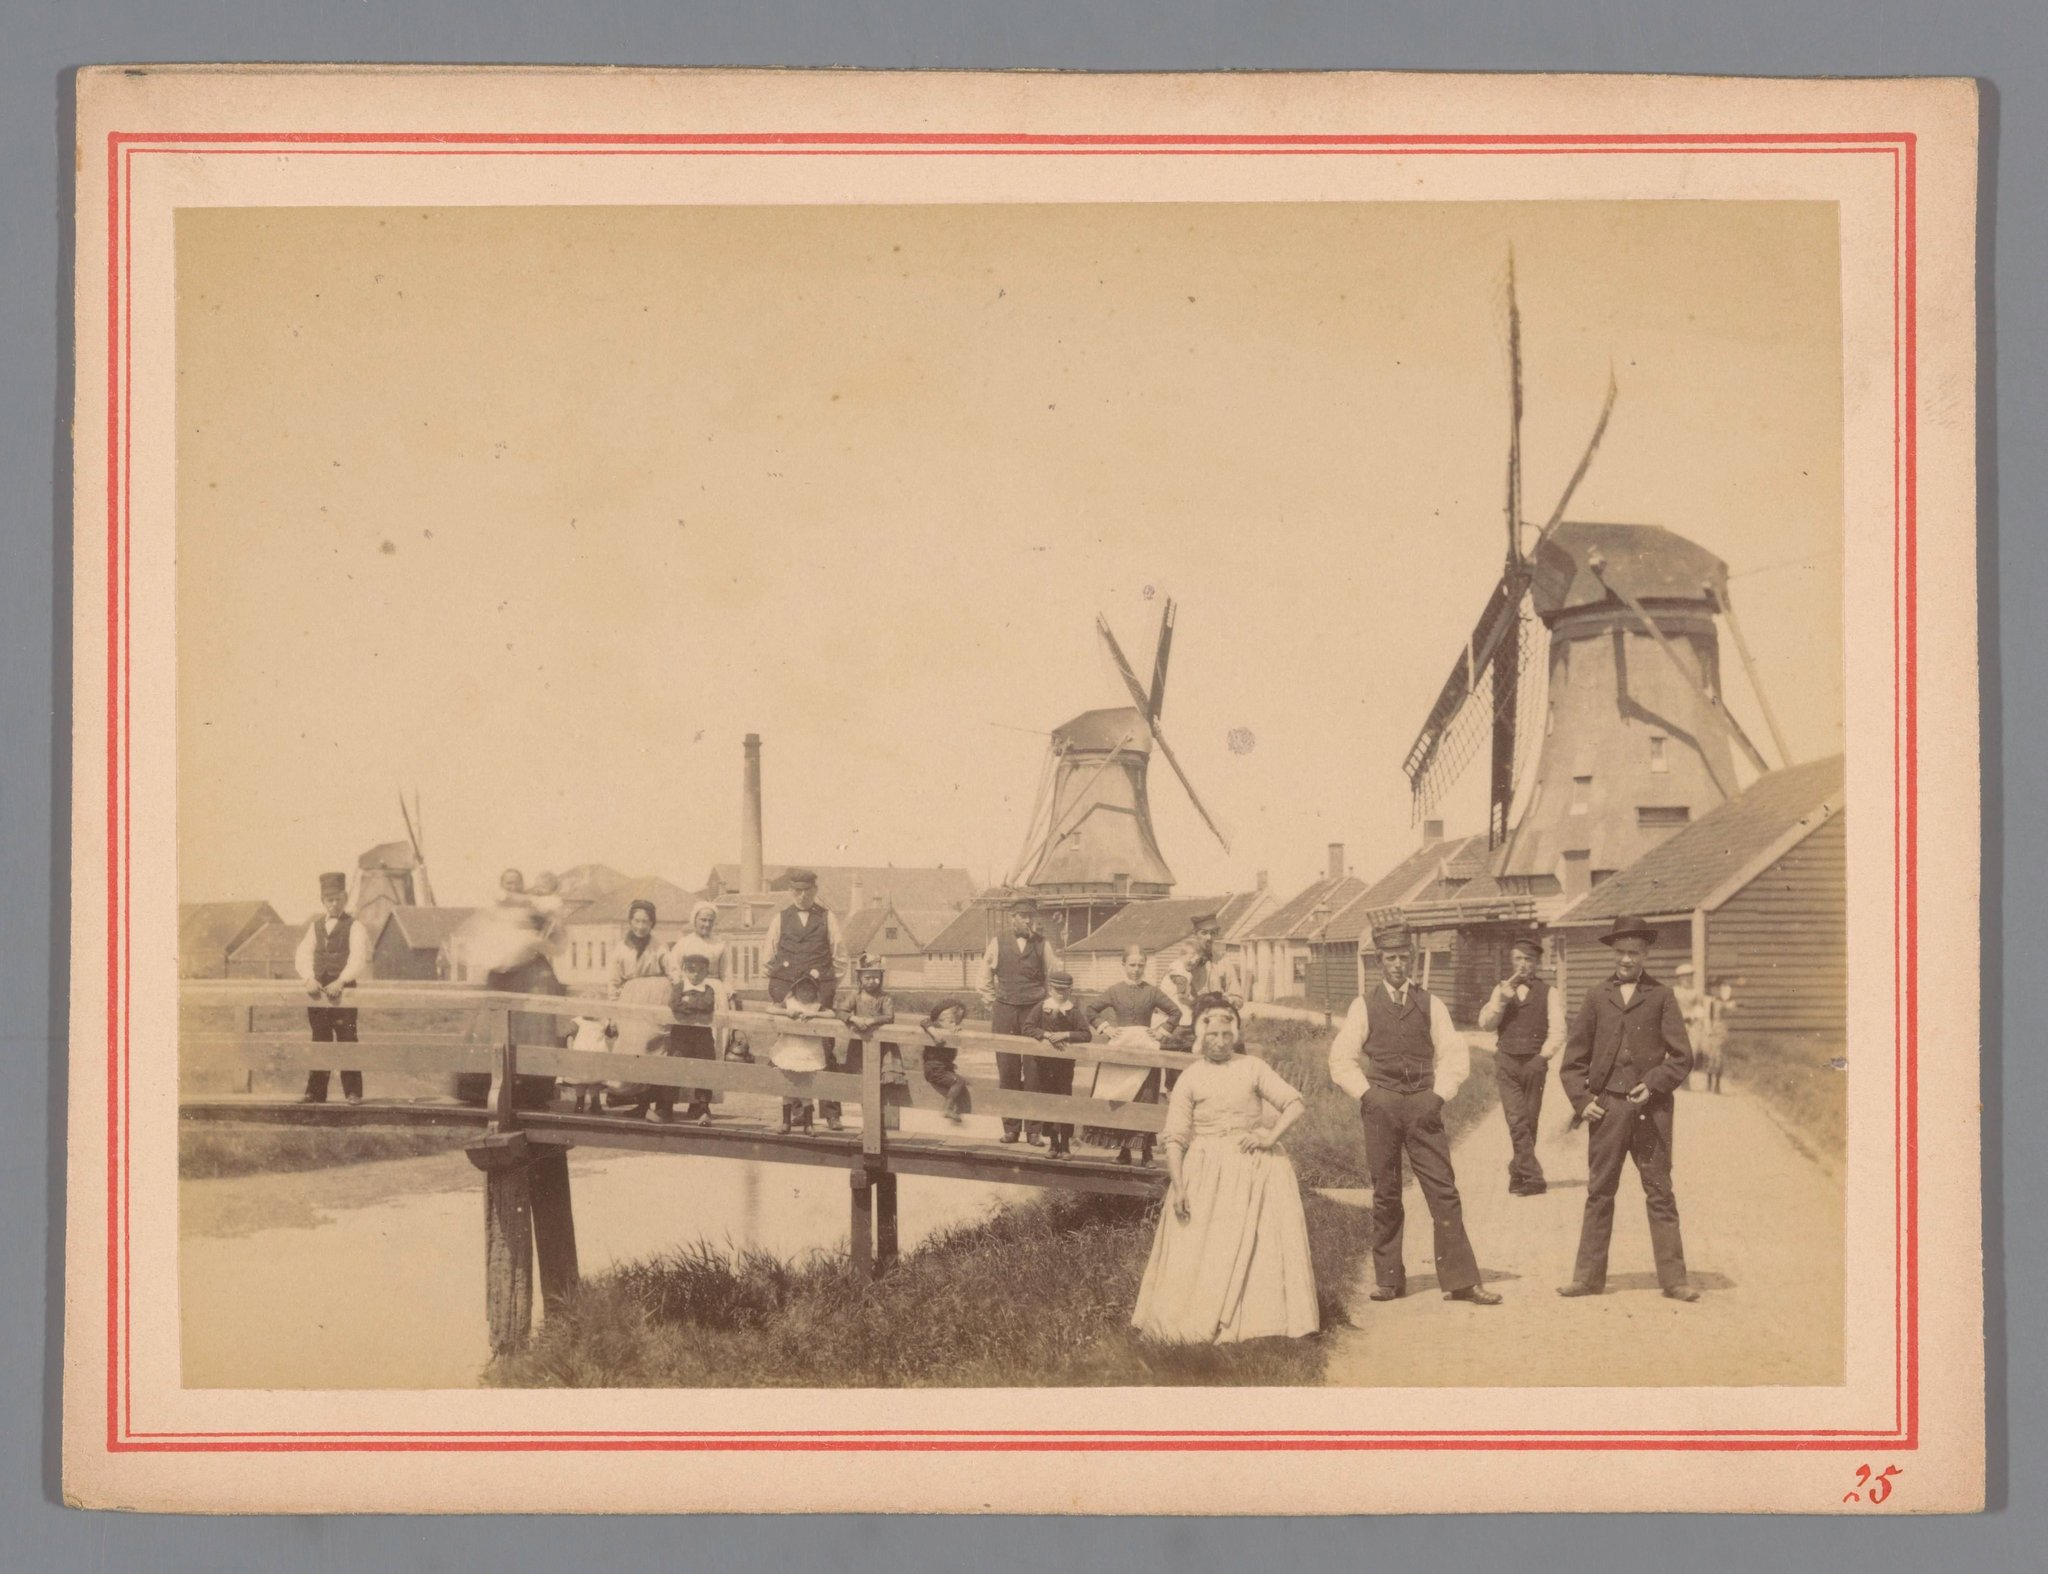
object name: cabinet photograph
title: Groepsportret in klederdracht op een brug bij de molens van Wormerveer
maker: Anonymous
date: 1850-1900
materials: cardboard, photographic support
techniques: albumen print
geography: wormerveer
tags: folk costume, regional costume, windmill, anonymous historical persons portrayed in a group, in a group-portrait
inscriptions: number: ‘25’, inscription: ‘Wormerveer’